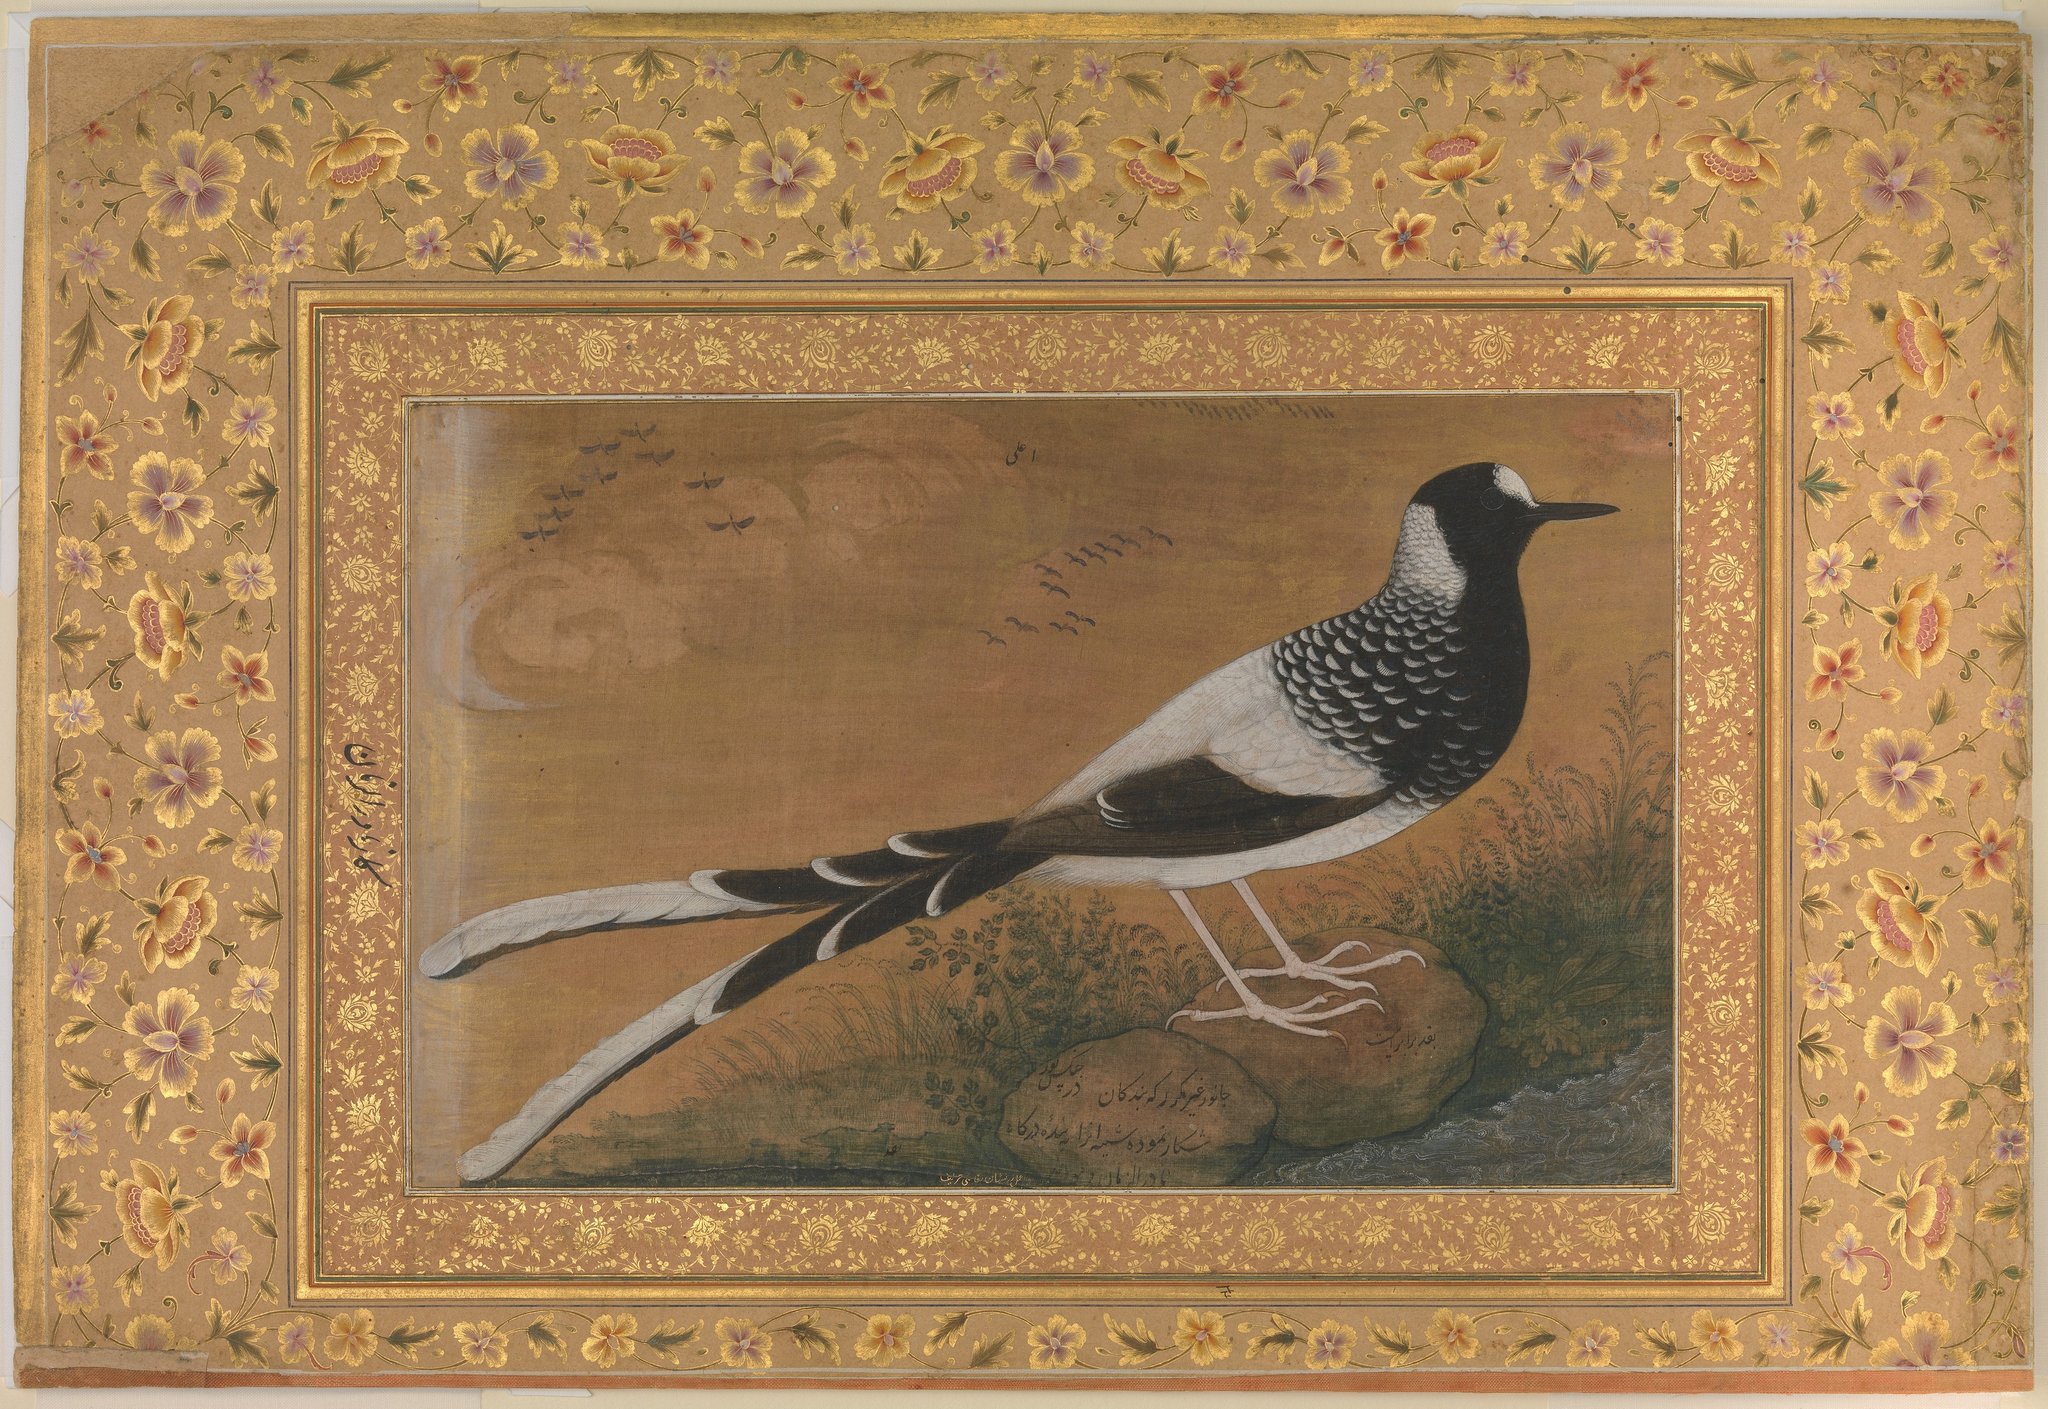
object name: album leaf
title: "Spotted Forktail", Folio from the Shah Jahan Album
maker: abu'l hasan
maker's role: artist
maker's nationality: indian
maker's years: 1588-1628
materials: gold, ink, silk, watercolor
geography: india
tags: birds,flowers